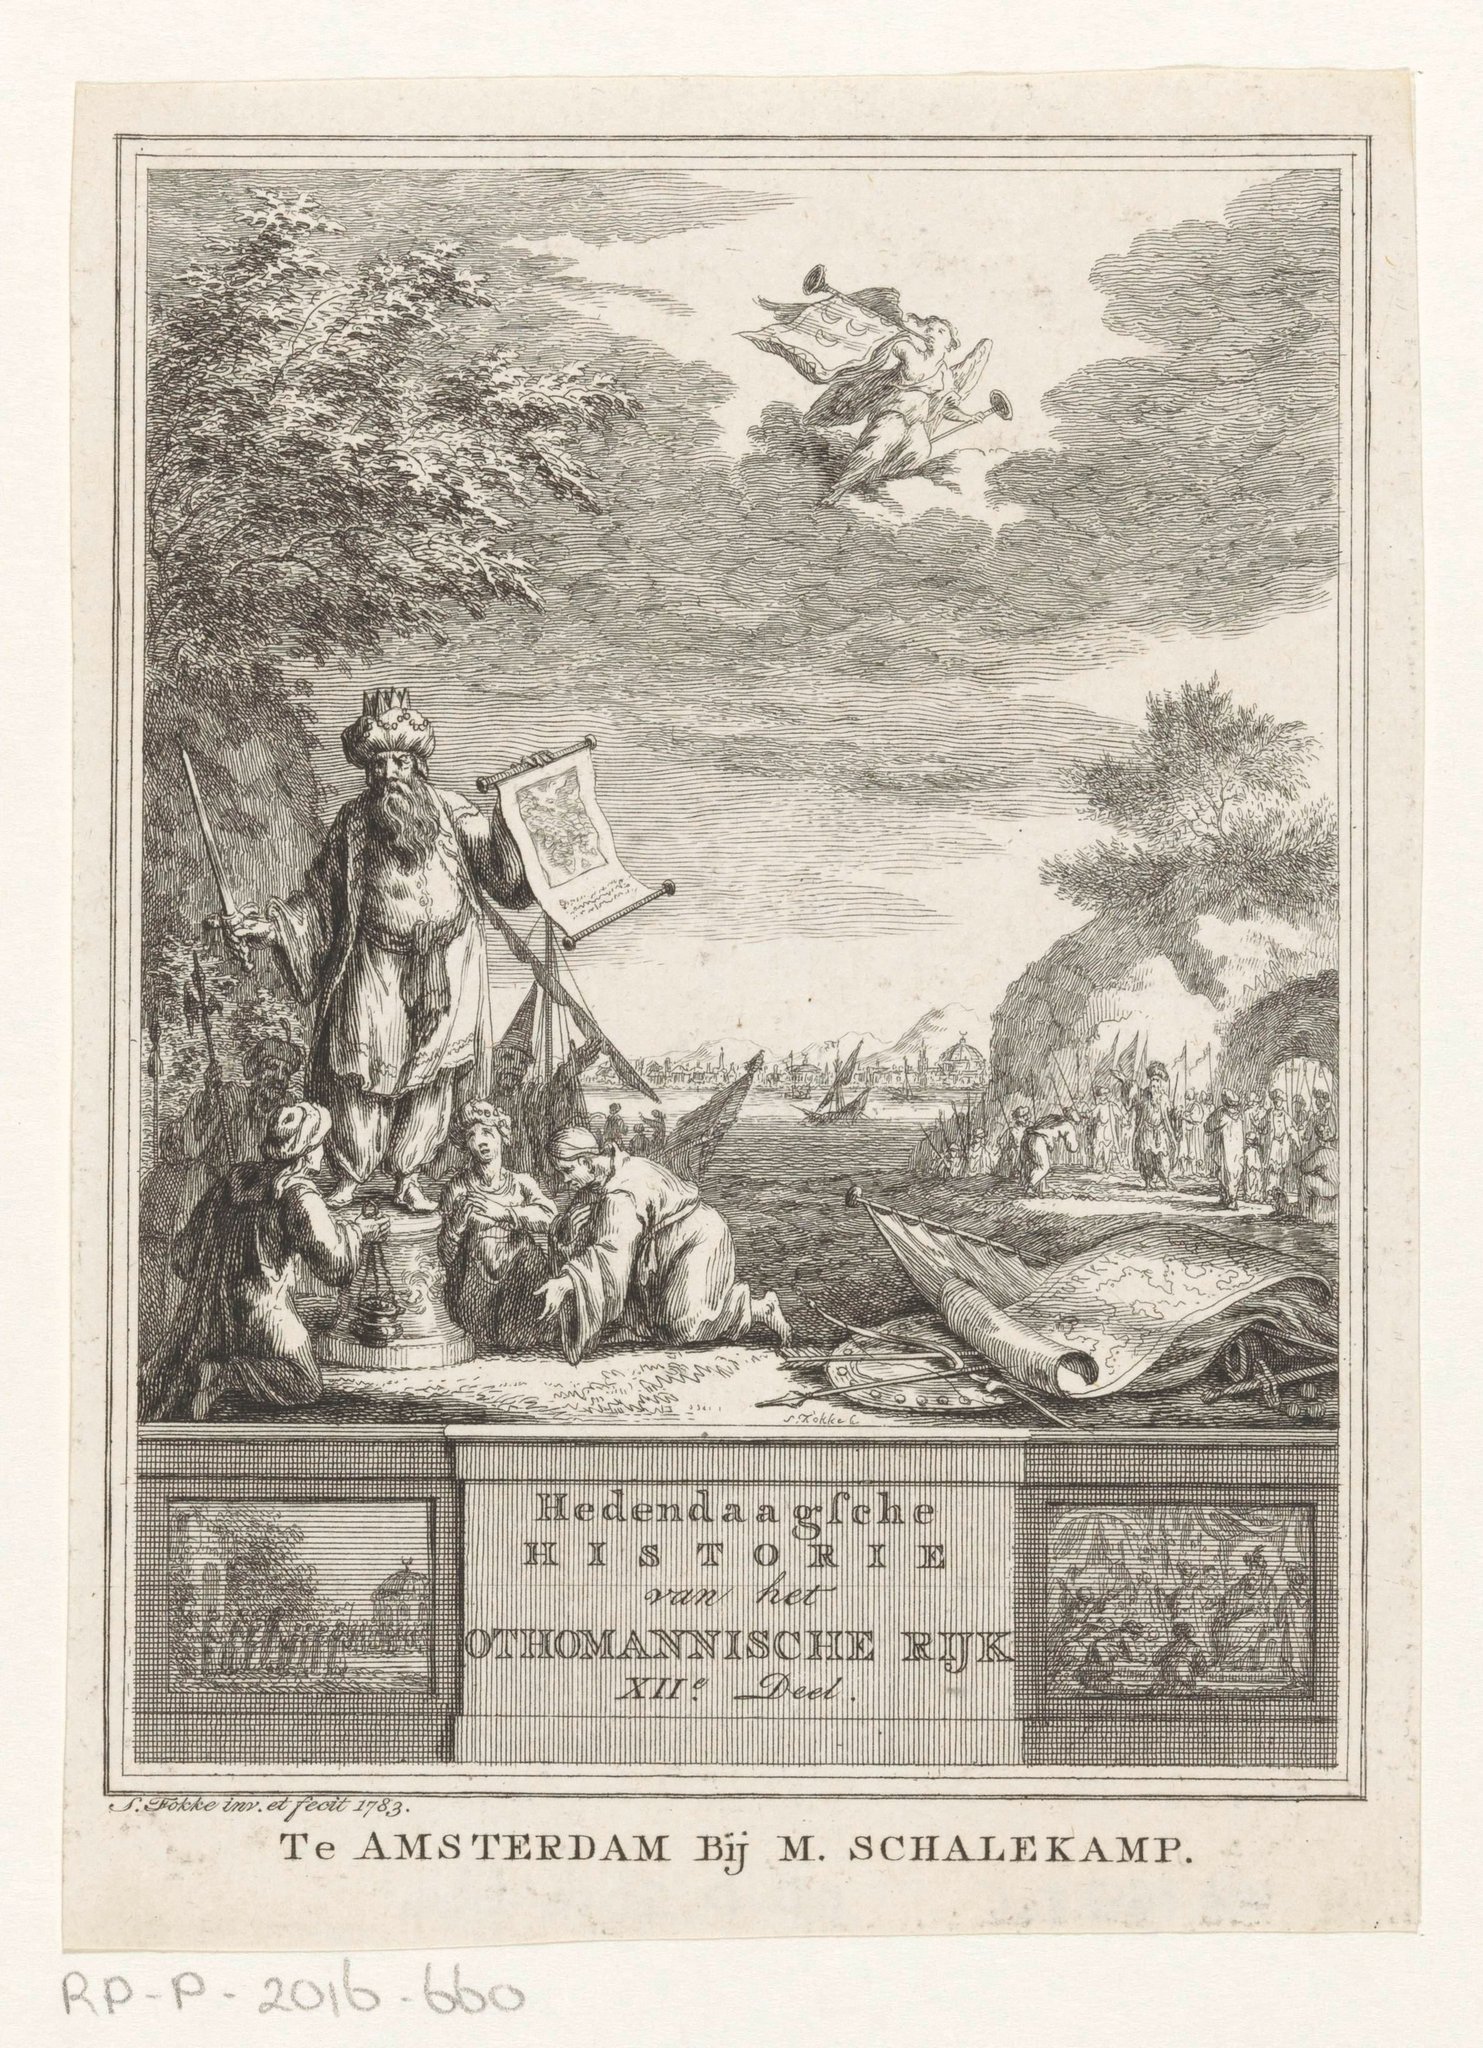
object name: print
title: Allegorie op Ottomaanse Rijk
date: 1783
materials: paper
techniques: engraving, etching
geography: amsterdam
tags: personifications of countries, nations, states, districts, etc.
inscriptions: collector's mark: Lugt 2228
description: Titelpagina voor: S.n. Hedendaagsche historie of Het vervolg van de Algemeene historie (...) XIIde deel. Amsterdam: Schalekamp, M., 1783. Prent afkomstig uit een plakalbum met titelprenten, ornamenten etc. op blauw papier in 1983 uit elkaar gehaald. Volgens een notitie op verso zat de prent op p. 203 van dit album.